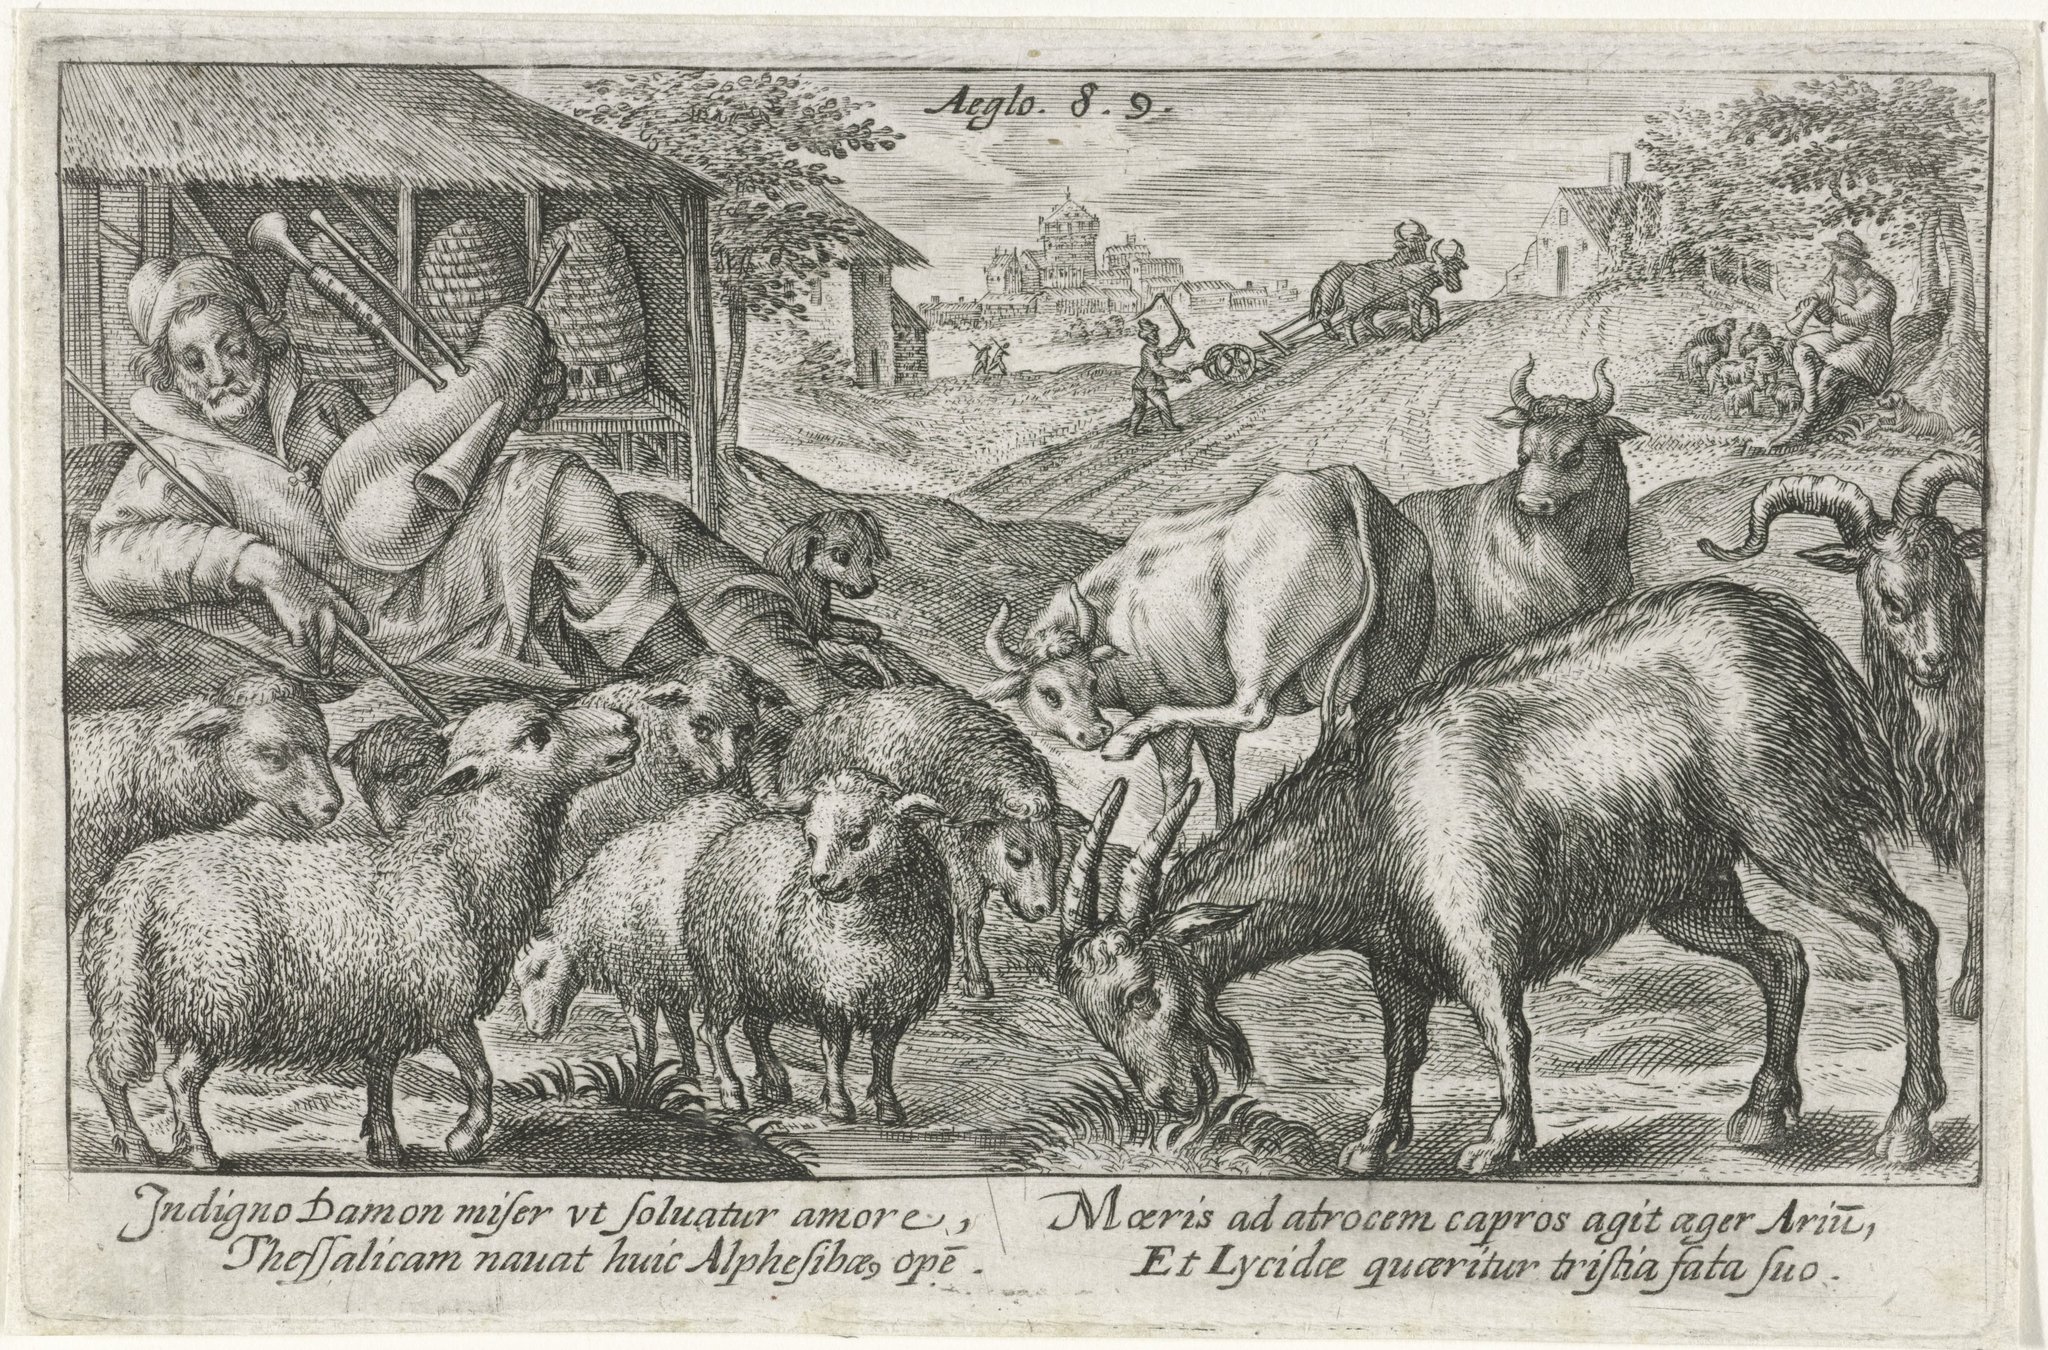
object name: print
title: Compendium Operum Virgilianorum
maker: crispijn van de passe (i)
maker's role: draughtsman, print maker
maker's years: 1564-1637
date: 1612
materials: paper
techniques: engraving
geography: utrecht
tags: (story of) damon, friend of pythias (phintias) - love-affairs of person from classical history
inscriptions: collector's mark: Lugt 2228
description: De herder Damon die doedelzak speelt, omringd door zijn kudde koeien en schapen. In de marge een vierregelig onderschrift, in twee kolommen, in het Latijn.